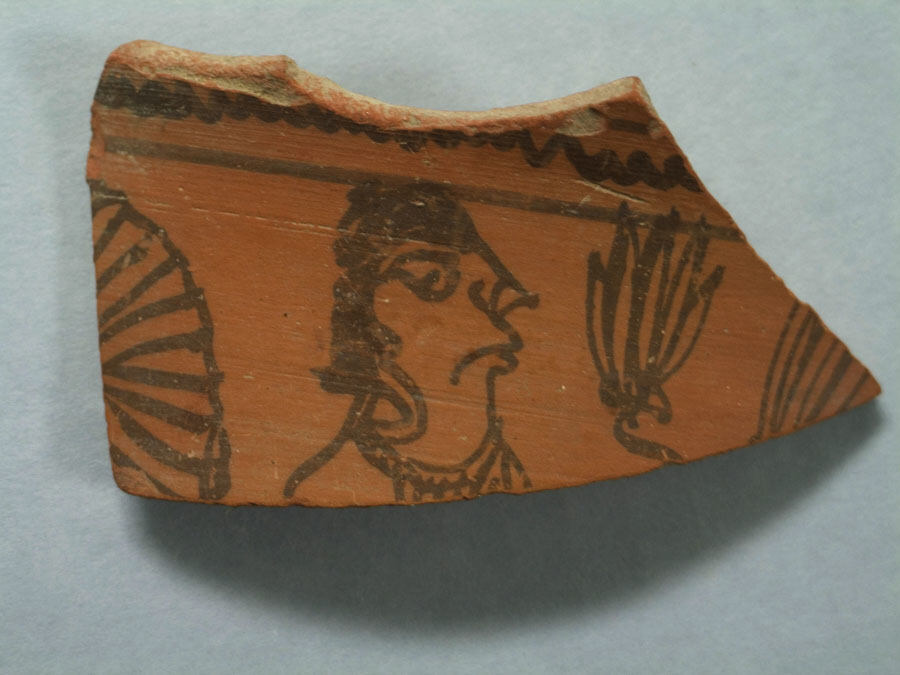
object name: shard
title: Shard: Head of Offerer with Plant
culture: pakistani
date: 301-500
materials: terracotta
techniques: painting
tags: gandhara,heads